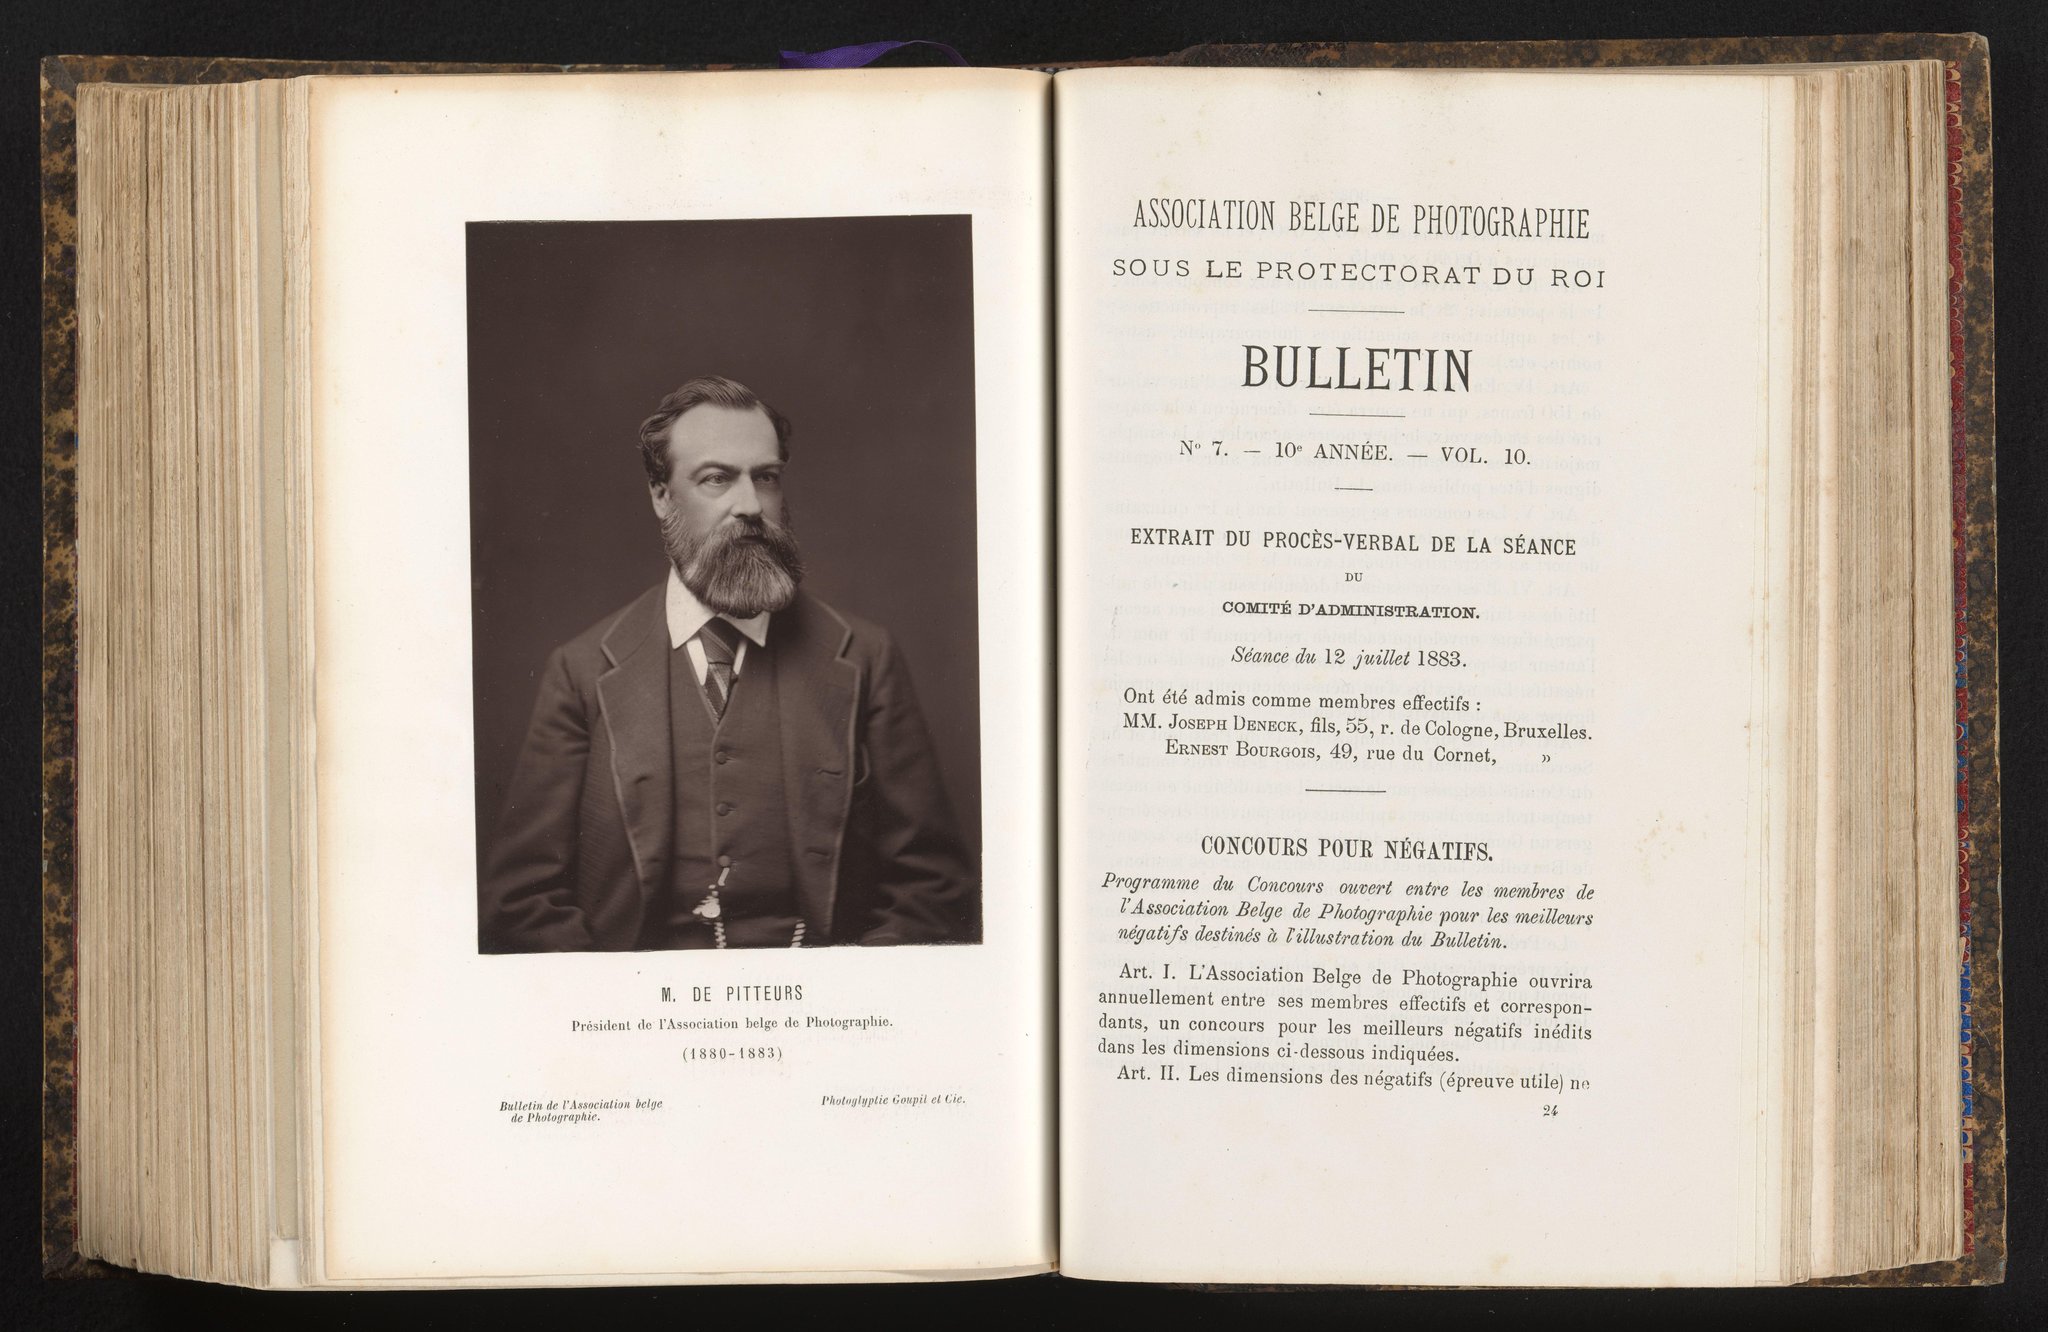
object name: photomechanical print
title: M. de Pitteurs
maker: Anonymous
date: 1878-1883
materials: paper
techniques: woodburytype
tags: brussels, charles de pitteurs, adult man, historical persons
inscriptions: inscription: ‘Président de l'Association belge de Photographie/ (1880 -1883)’, inscription: ‘Bulletin de l'Association belge de Photographie’